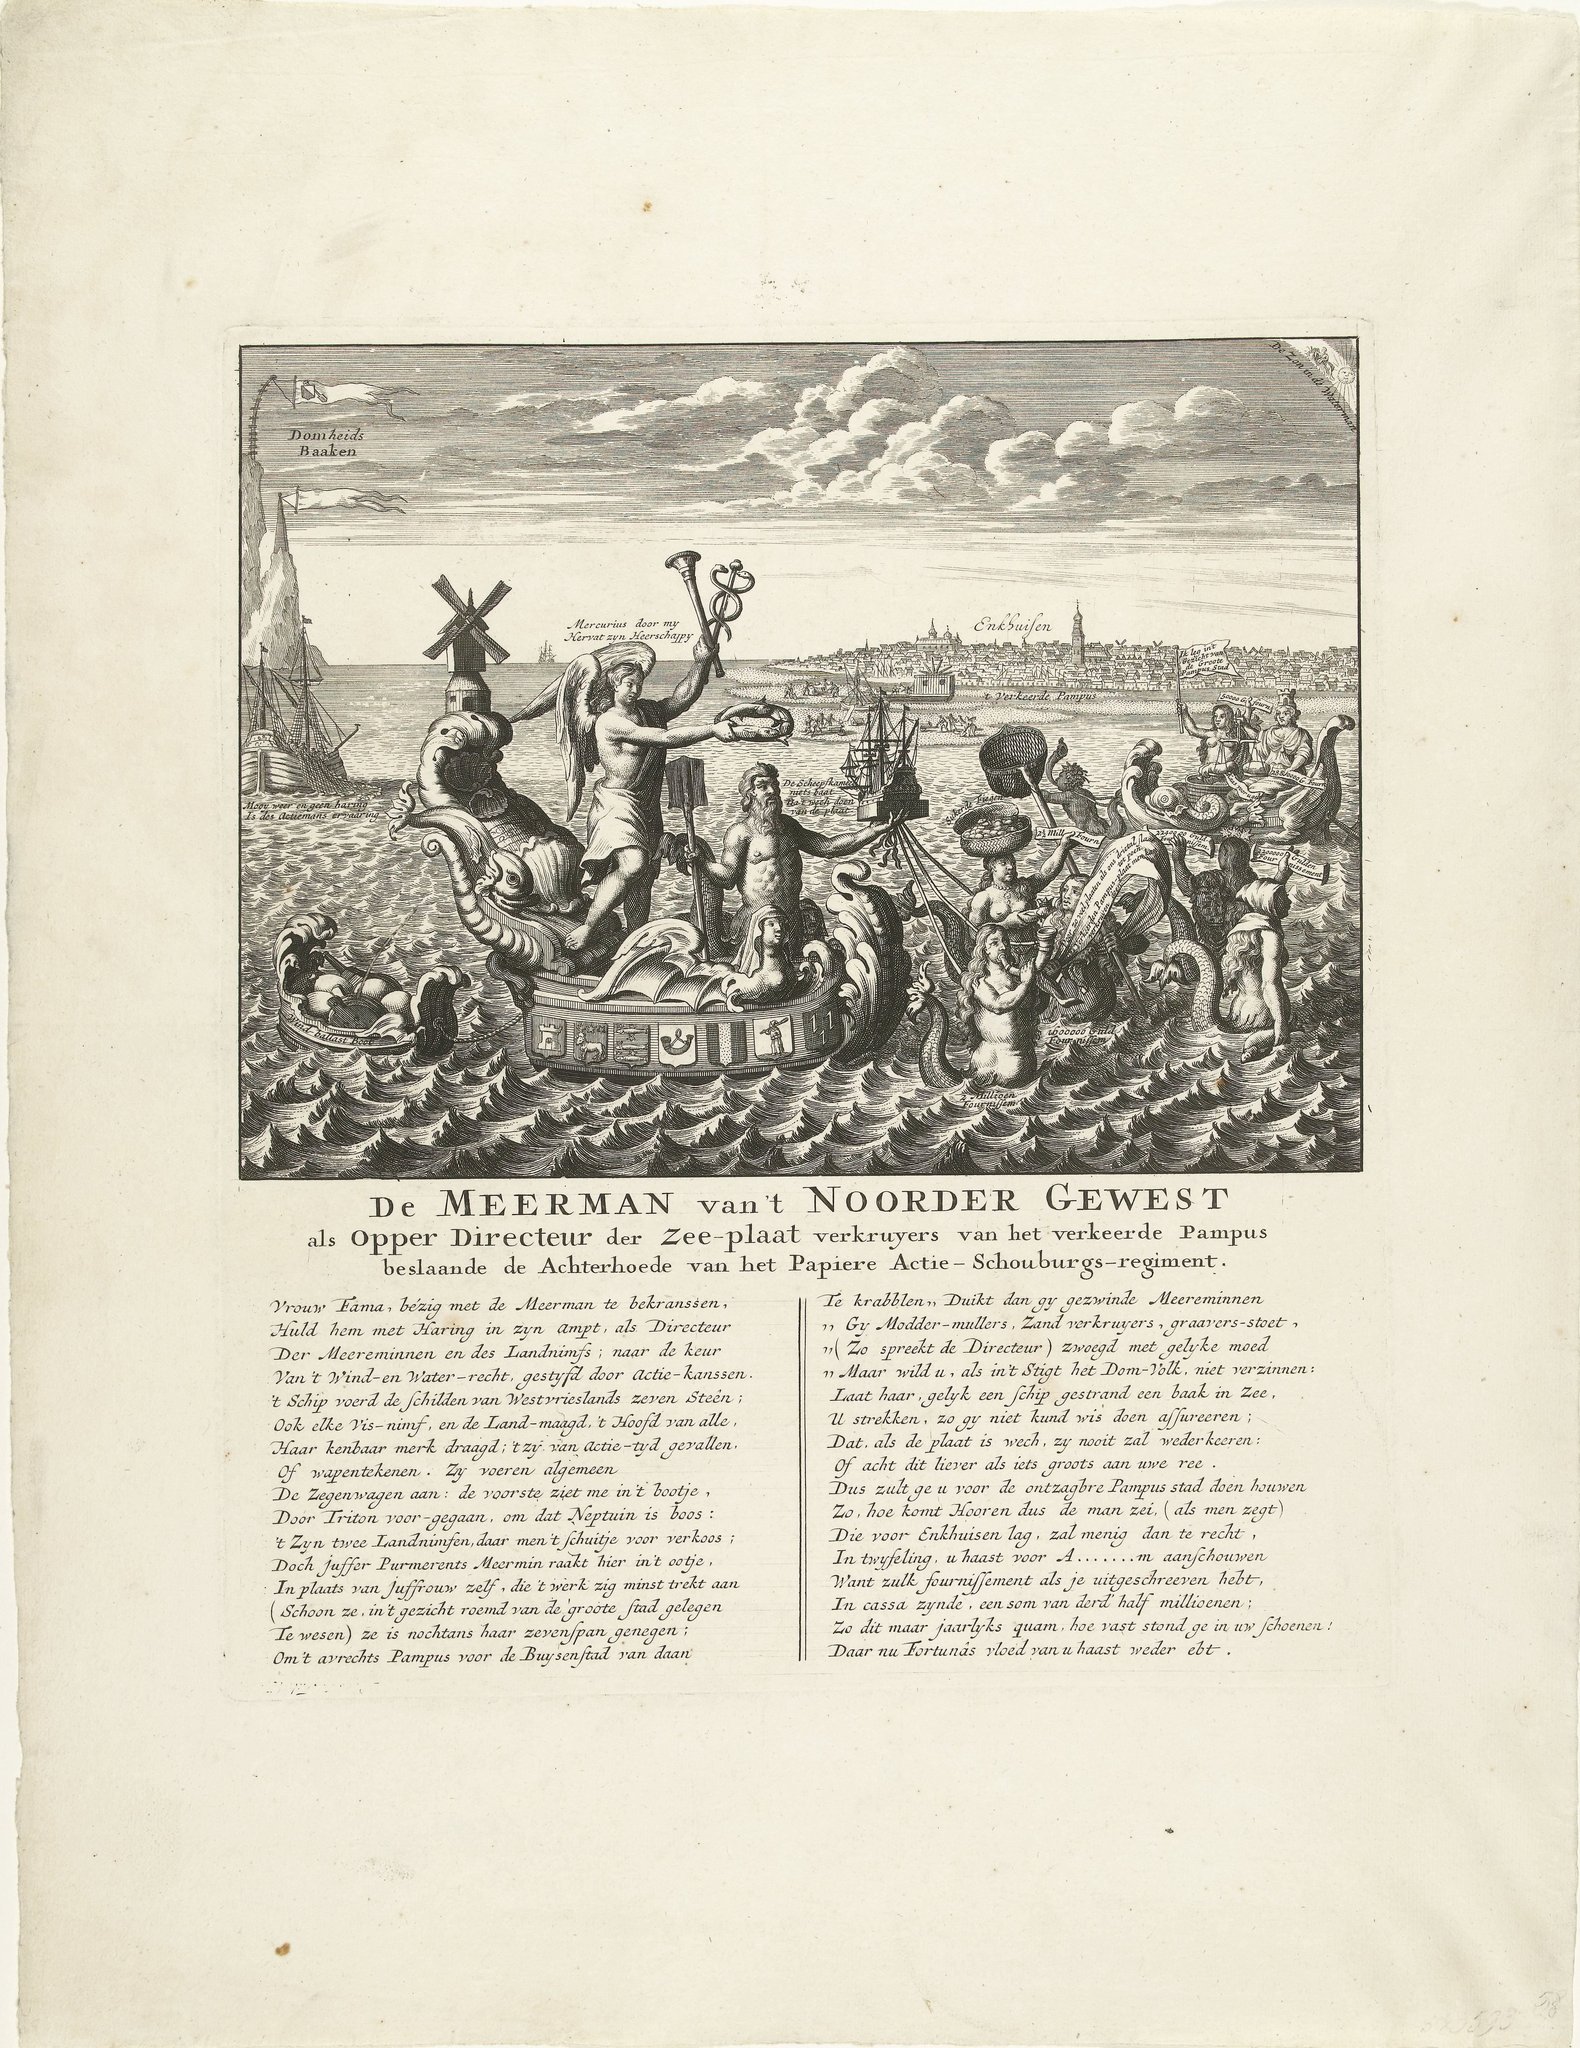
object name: print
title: De Meerman van 't Noorder Gewest als Opper Directeur der Zee-plaat verkruyers van het verkeerde Pampus beslaande de Achterhoede van het Papiere Actie-Schouburgs-regiment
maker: Anonymous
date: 1720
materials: paper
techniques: engraving, etching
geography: northern netherlands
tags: merman, fame; 'fama', 'fama buona', 'fama chiara' (ripa), enkhuizen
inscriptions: collector's mark: Lugt 2228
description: Schuitje versierd met de wapens van de zeven steden van het Noorderkwartier waarin een meerman gekroond wordt door de Faam, de boot wordt getrokken door zeemeerminnen. In het verschiet Enkhuizen waar de actionisten in 1720 een haven wilden aanleggen. Met onderschrift in twee kolommen. Prent 58 in de serie Het Groote Tafereel der Dwaasheid met spotprenten op de Windhandel of Actiehandel van 1720.